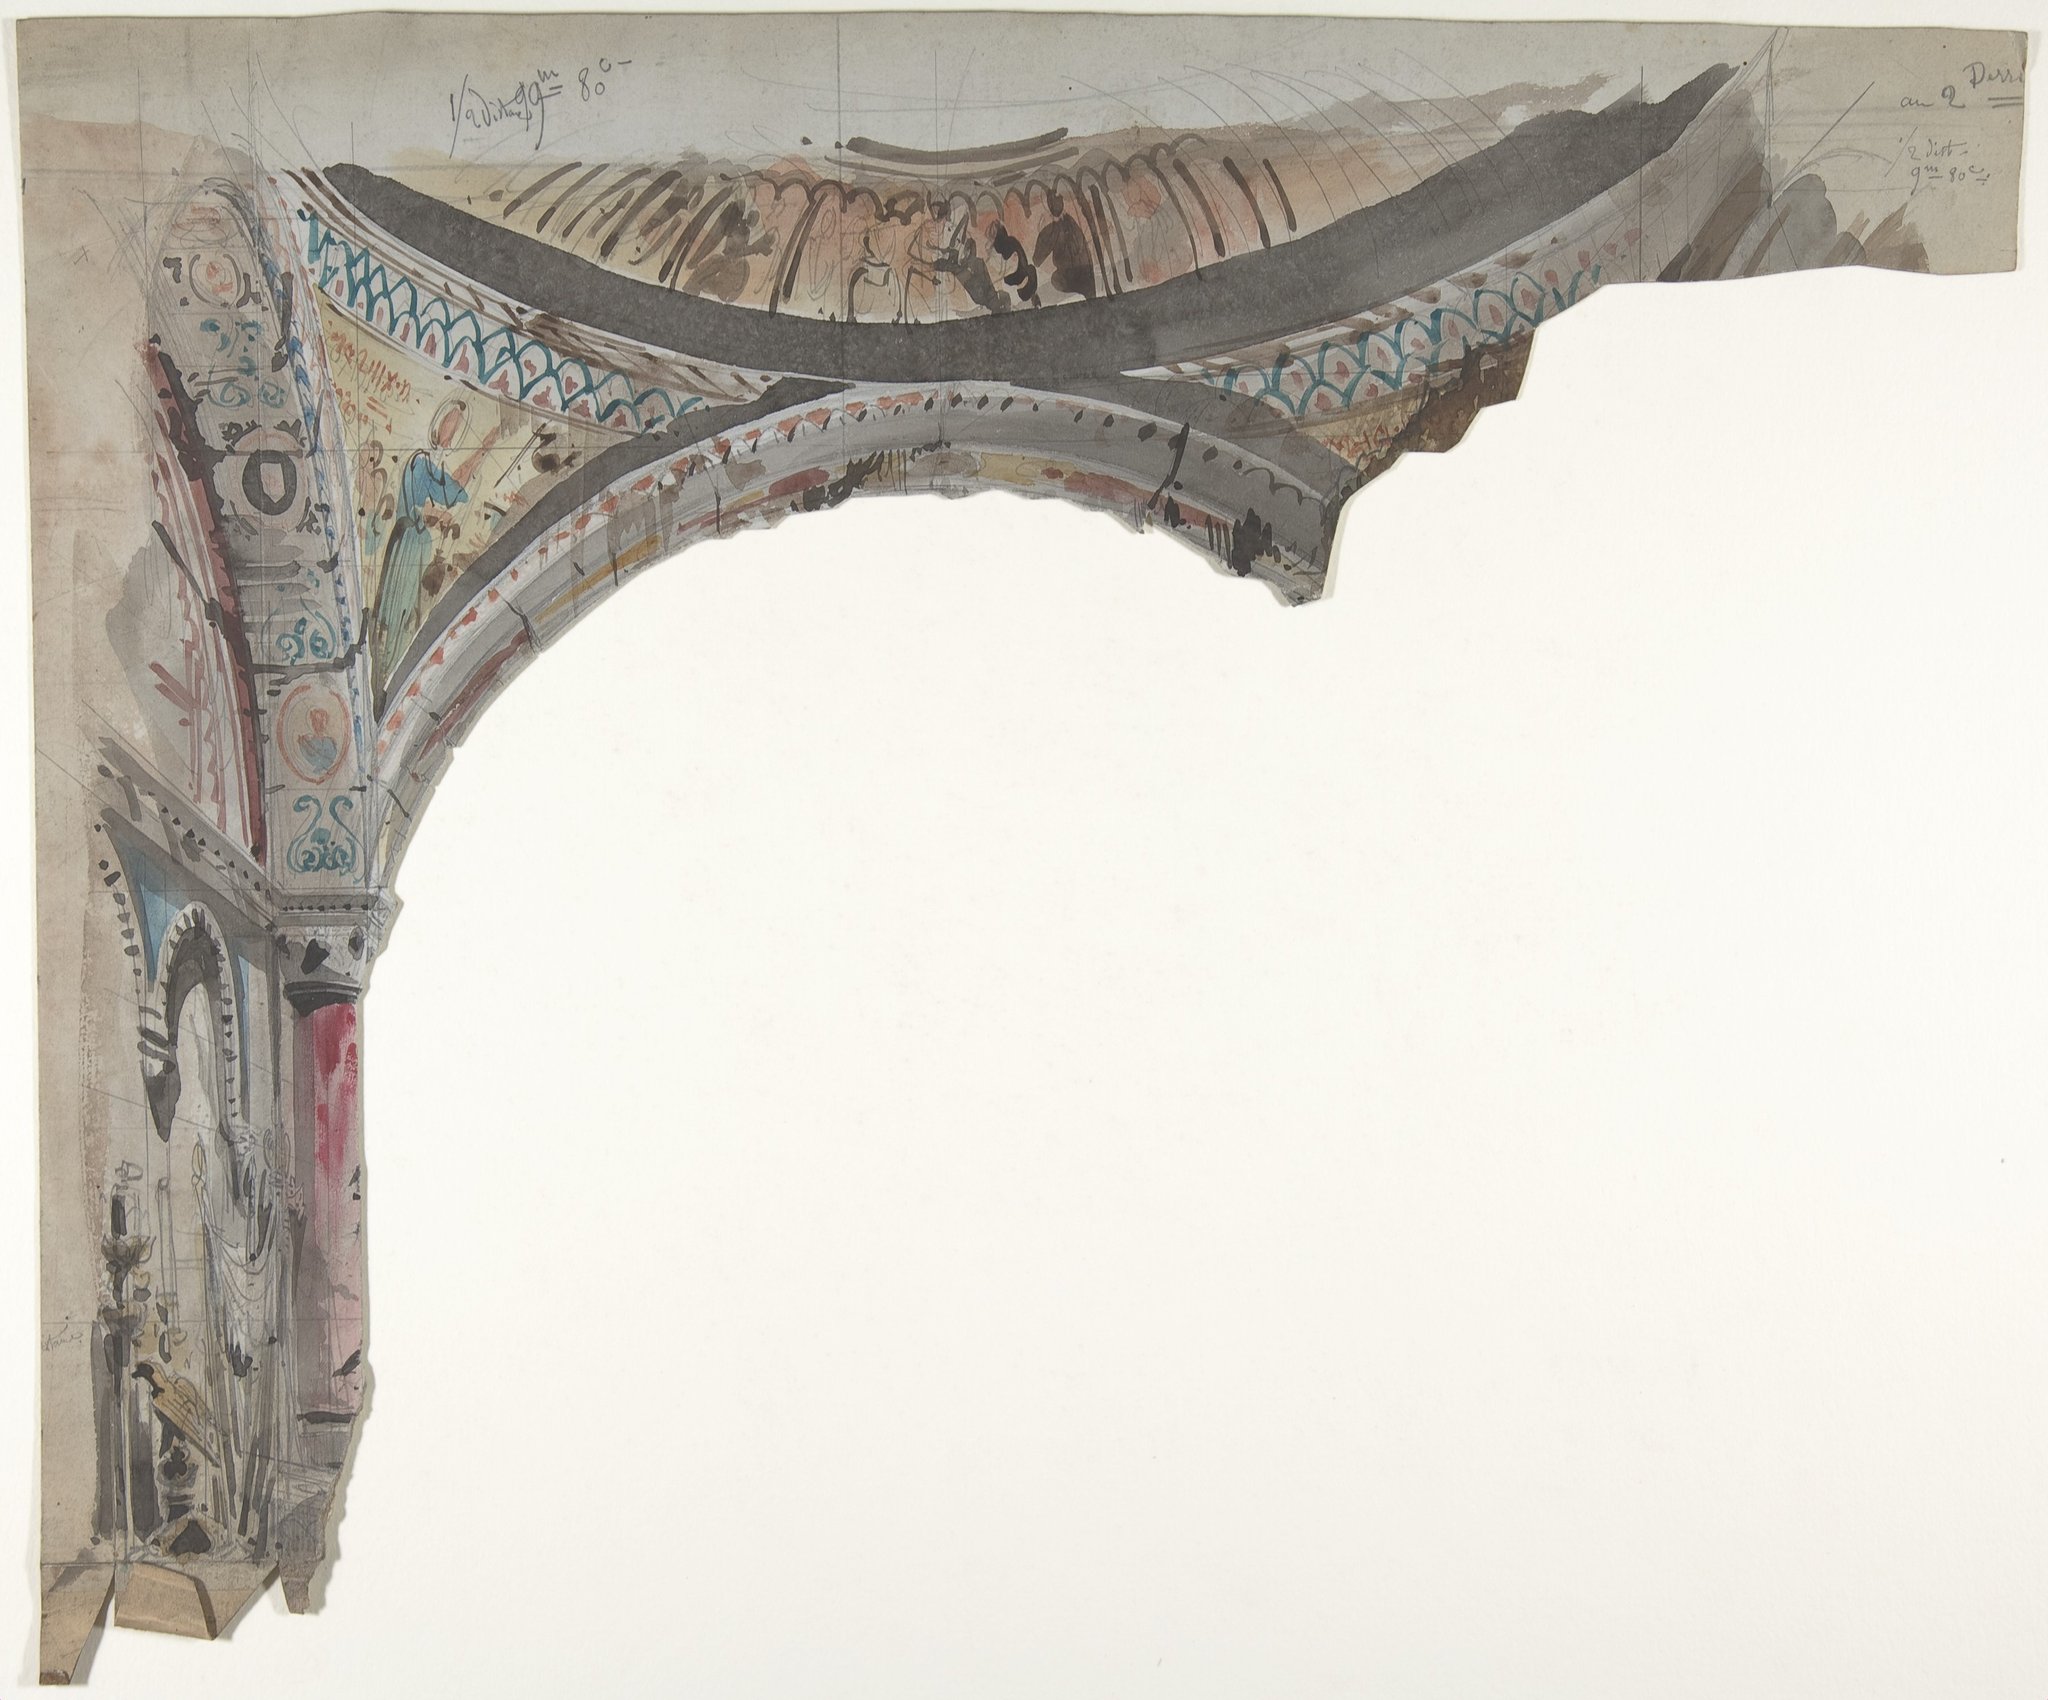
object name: drawing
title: Design for a Stage Set at the Opéra, Paris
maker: eugène cicéri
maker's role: artist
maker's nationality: french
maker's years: 1813-1890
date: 1830-1890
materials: graphite, watercolor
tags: stage design